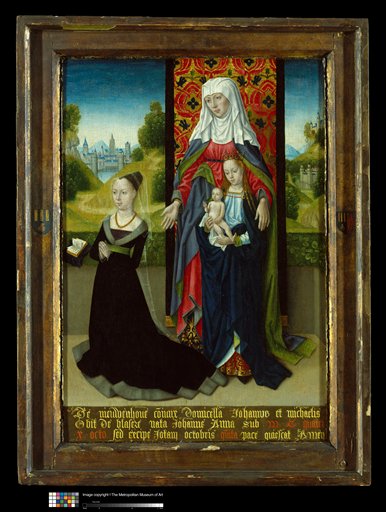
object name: frame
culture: dutch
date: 1467-1500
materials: wood